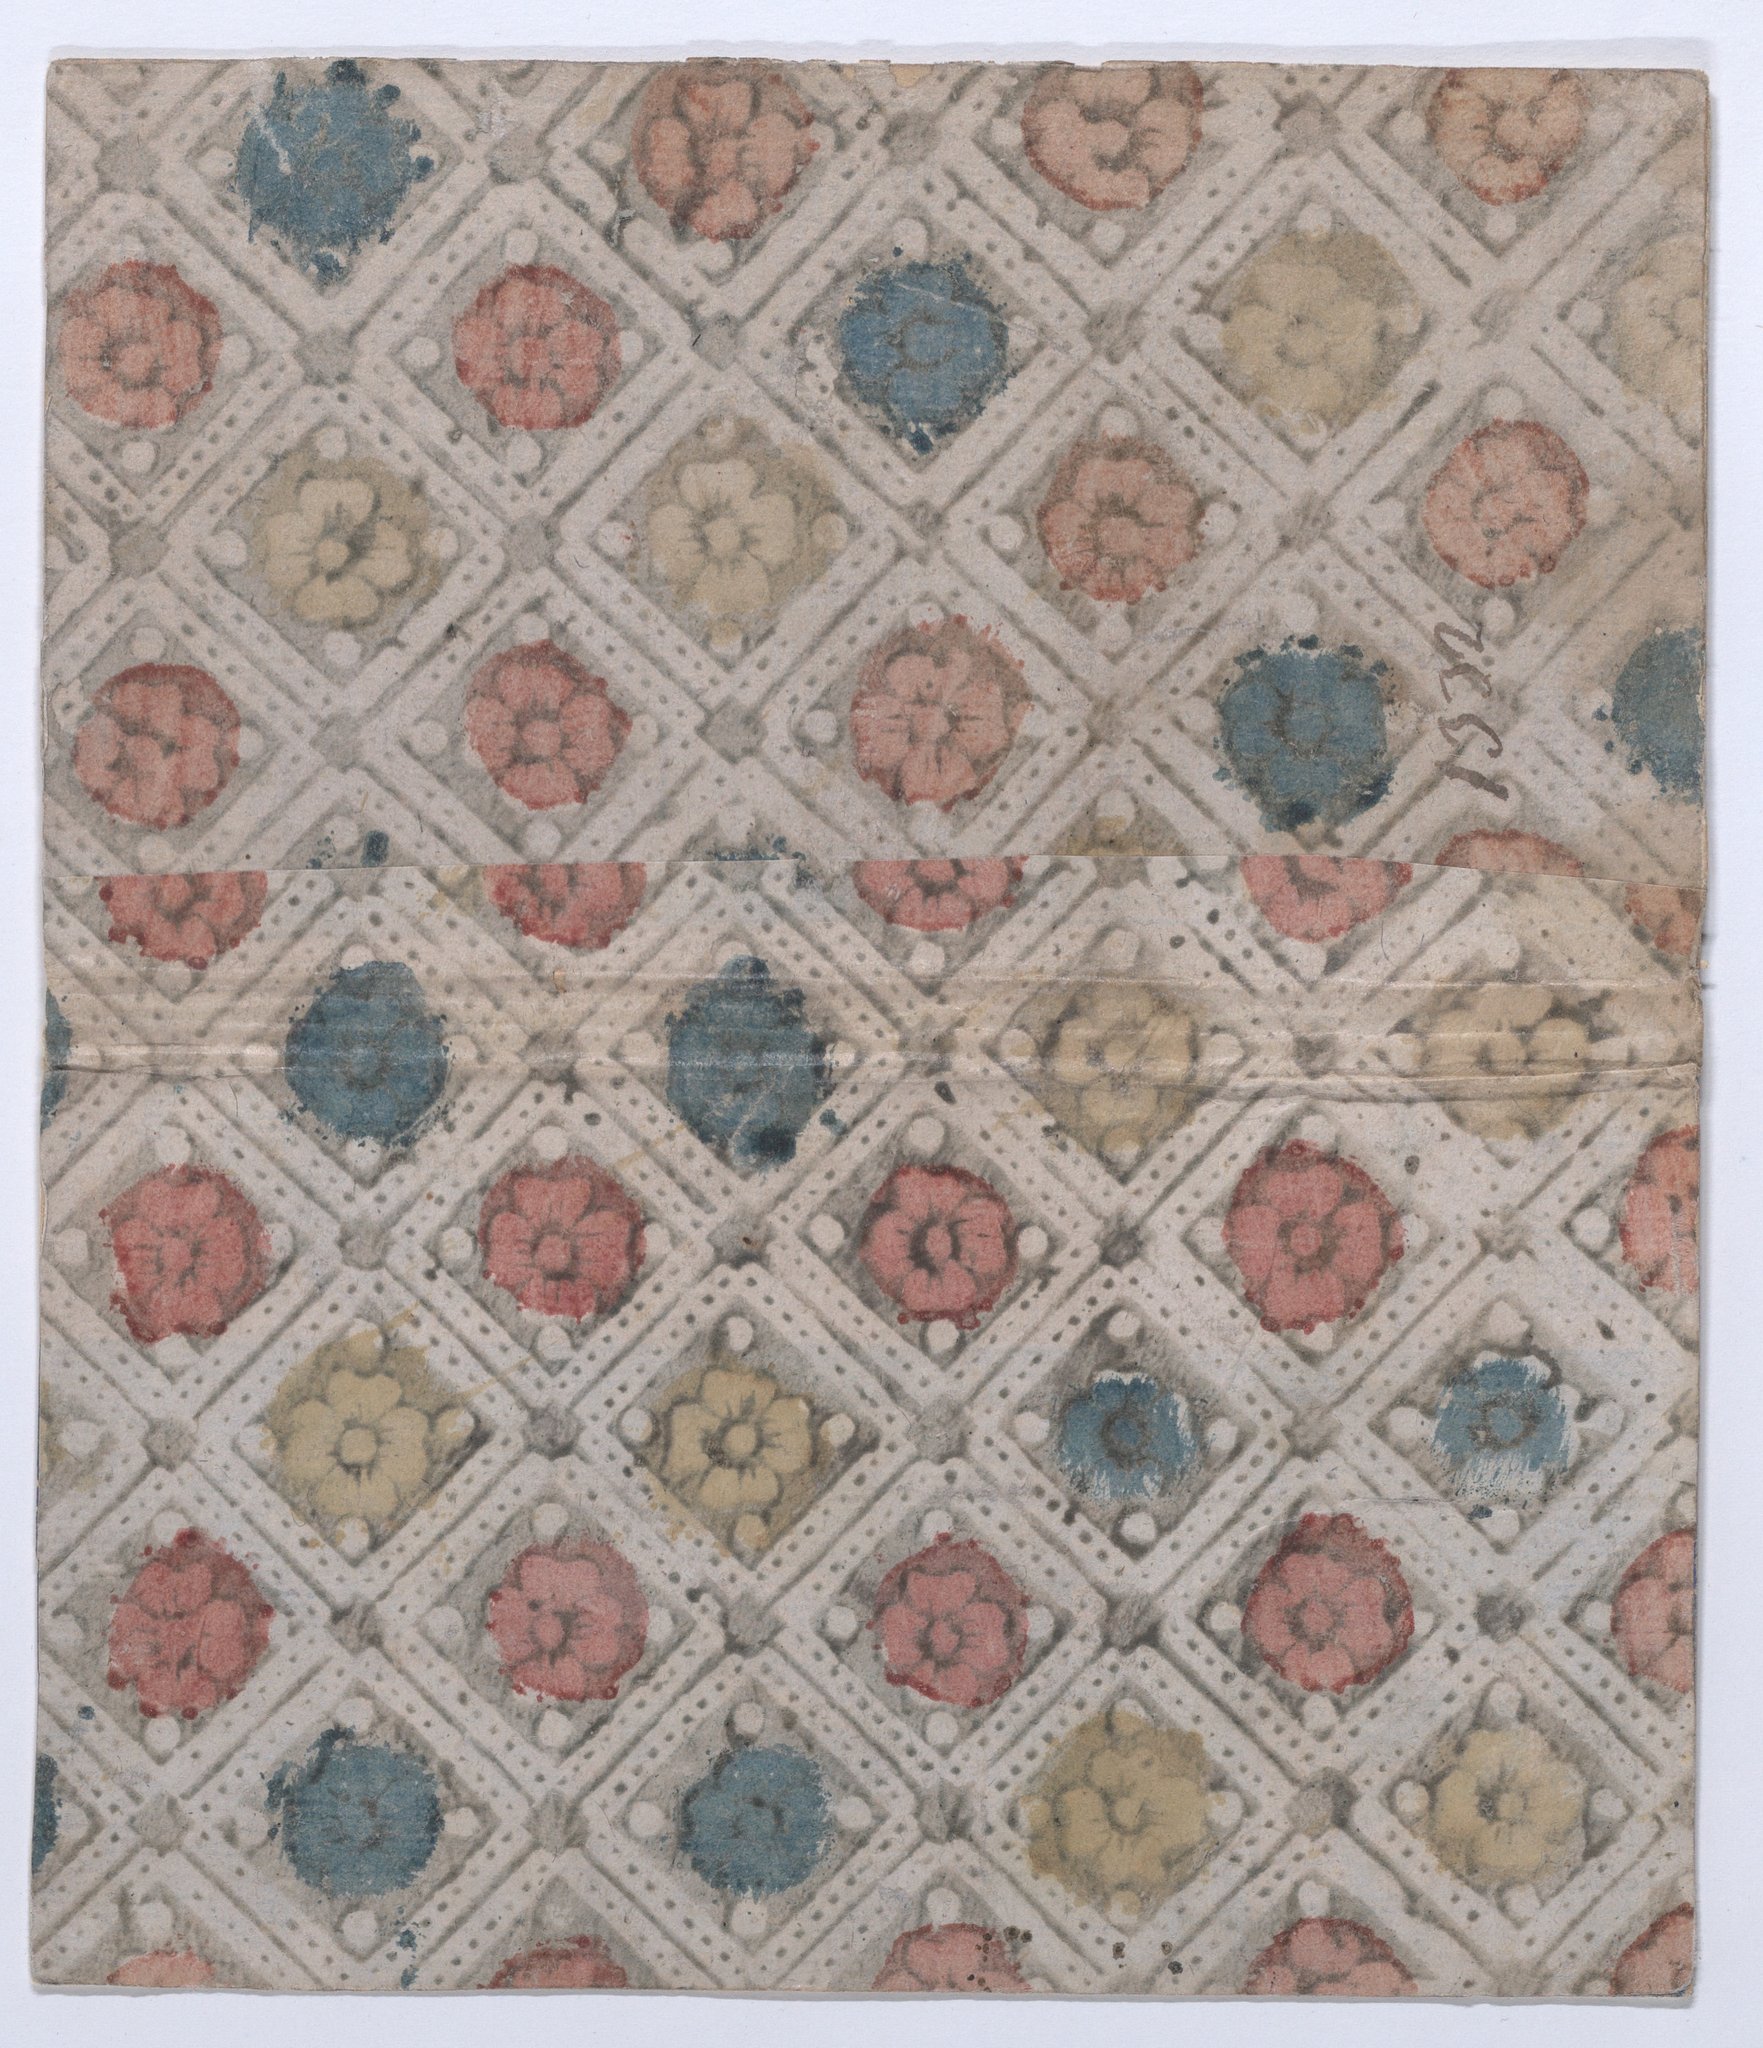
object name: print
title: Book cover with overall pattern of rosettes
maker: Anonymous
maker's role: artist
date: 1801-1900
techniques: relief print